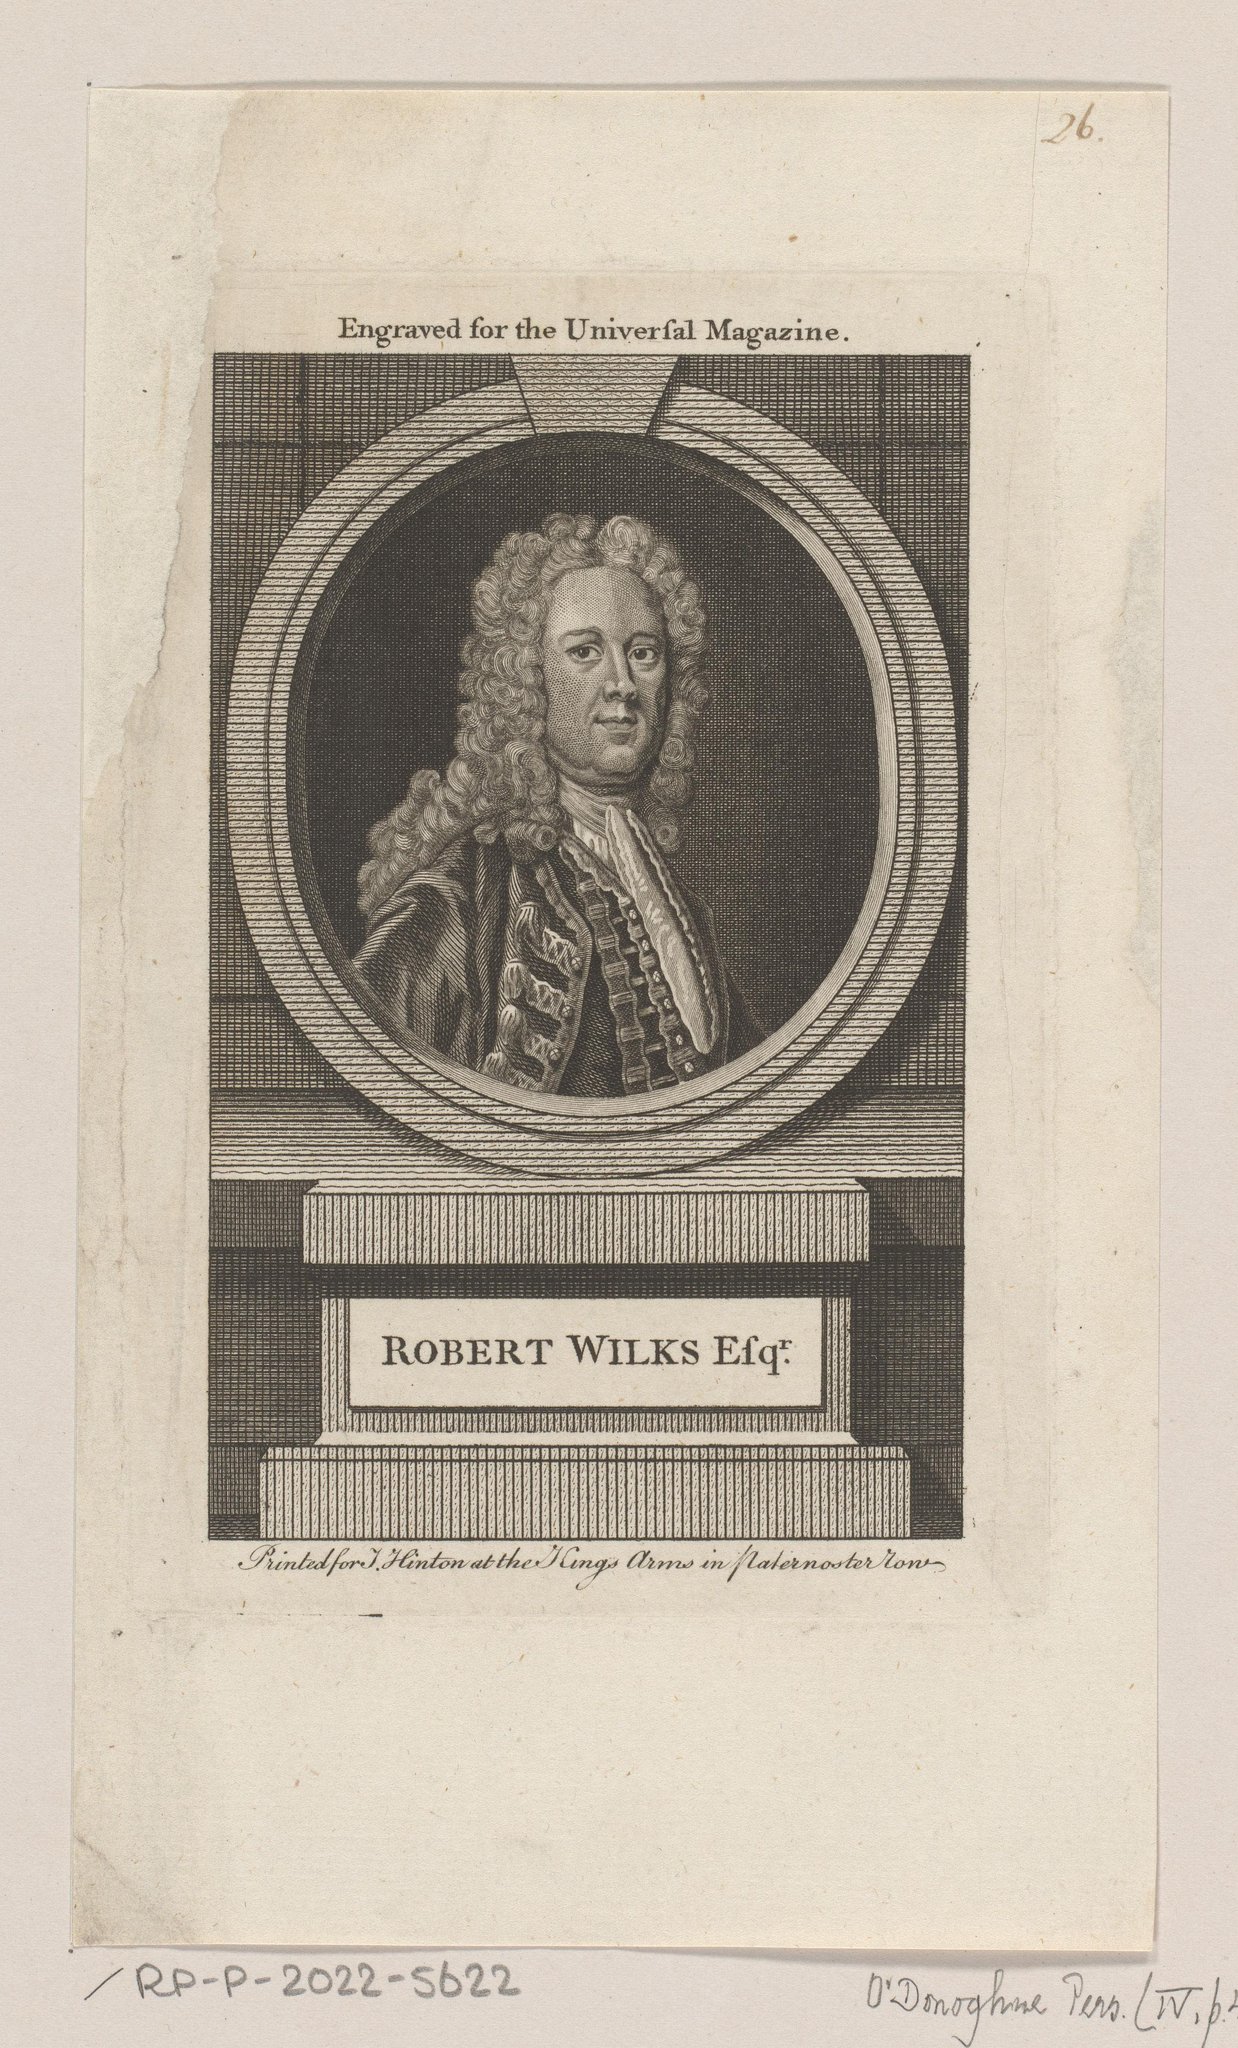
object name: print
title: Portret van Robert Wilks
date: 1747-1814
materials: paper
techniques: engraving, etching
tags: historical persons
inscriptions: number: ‘26.’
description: Prent mogelijk afkomstig uit een volume van The Universal magazine of Knowledge and Pleasure (1747-1814).